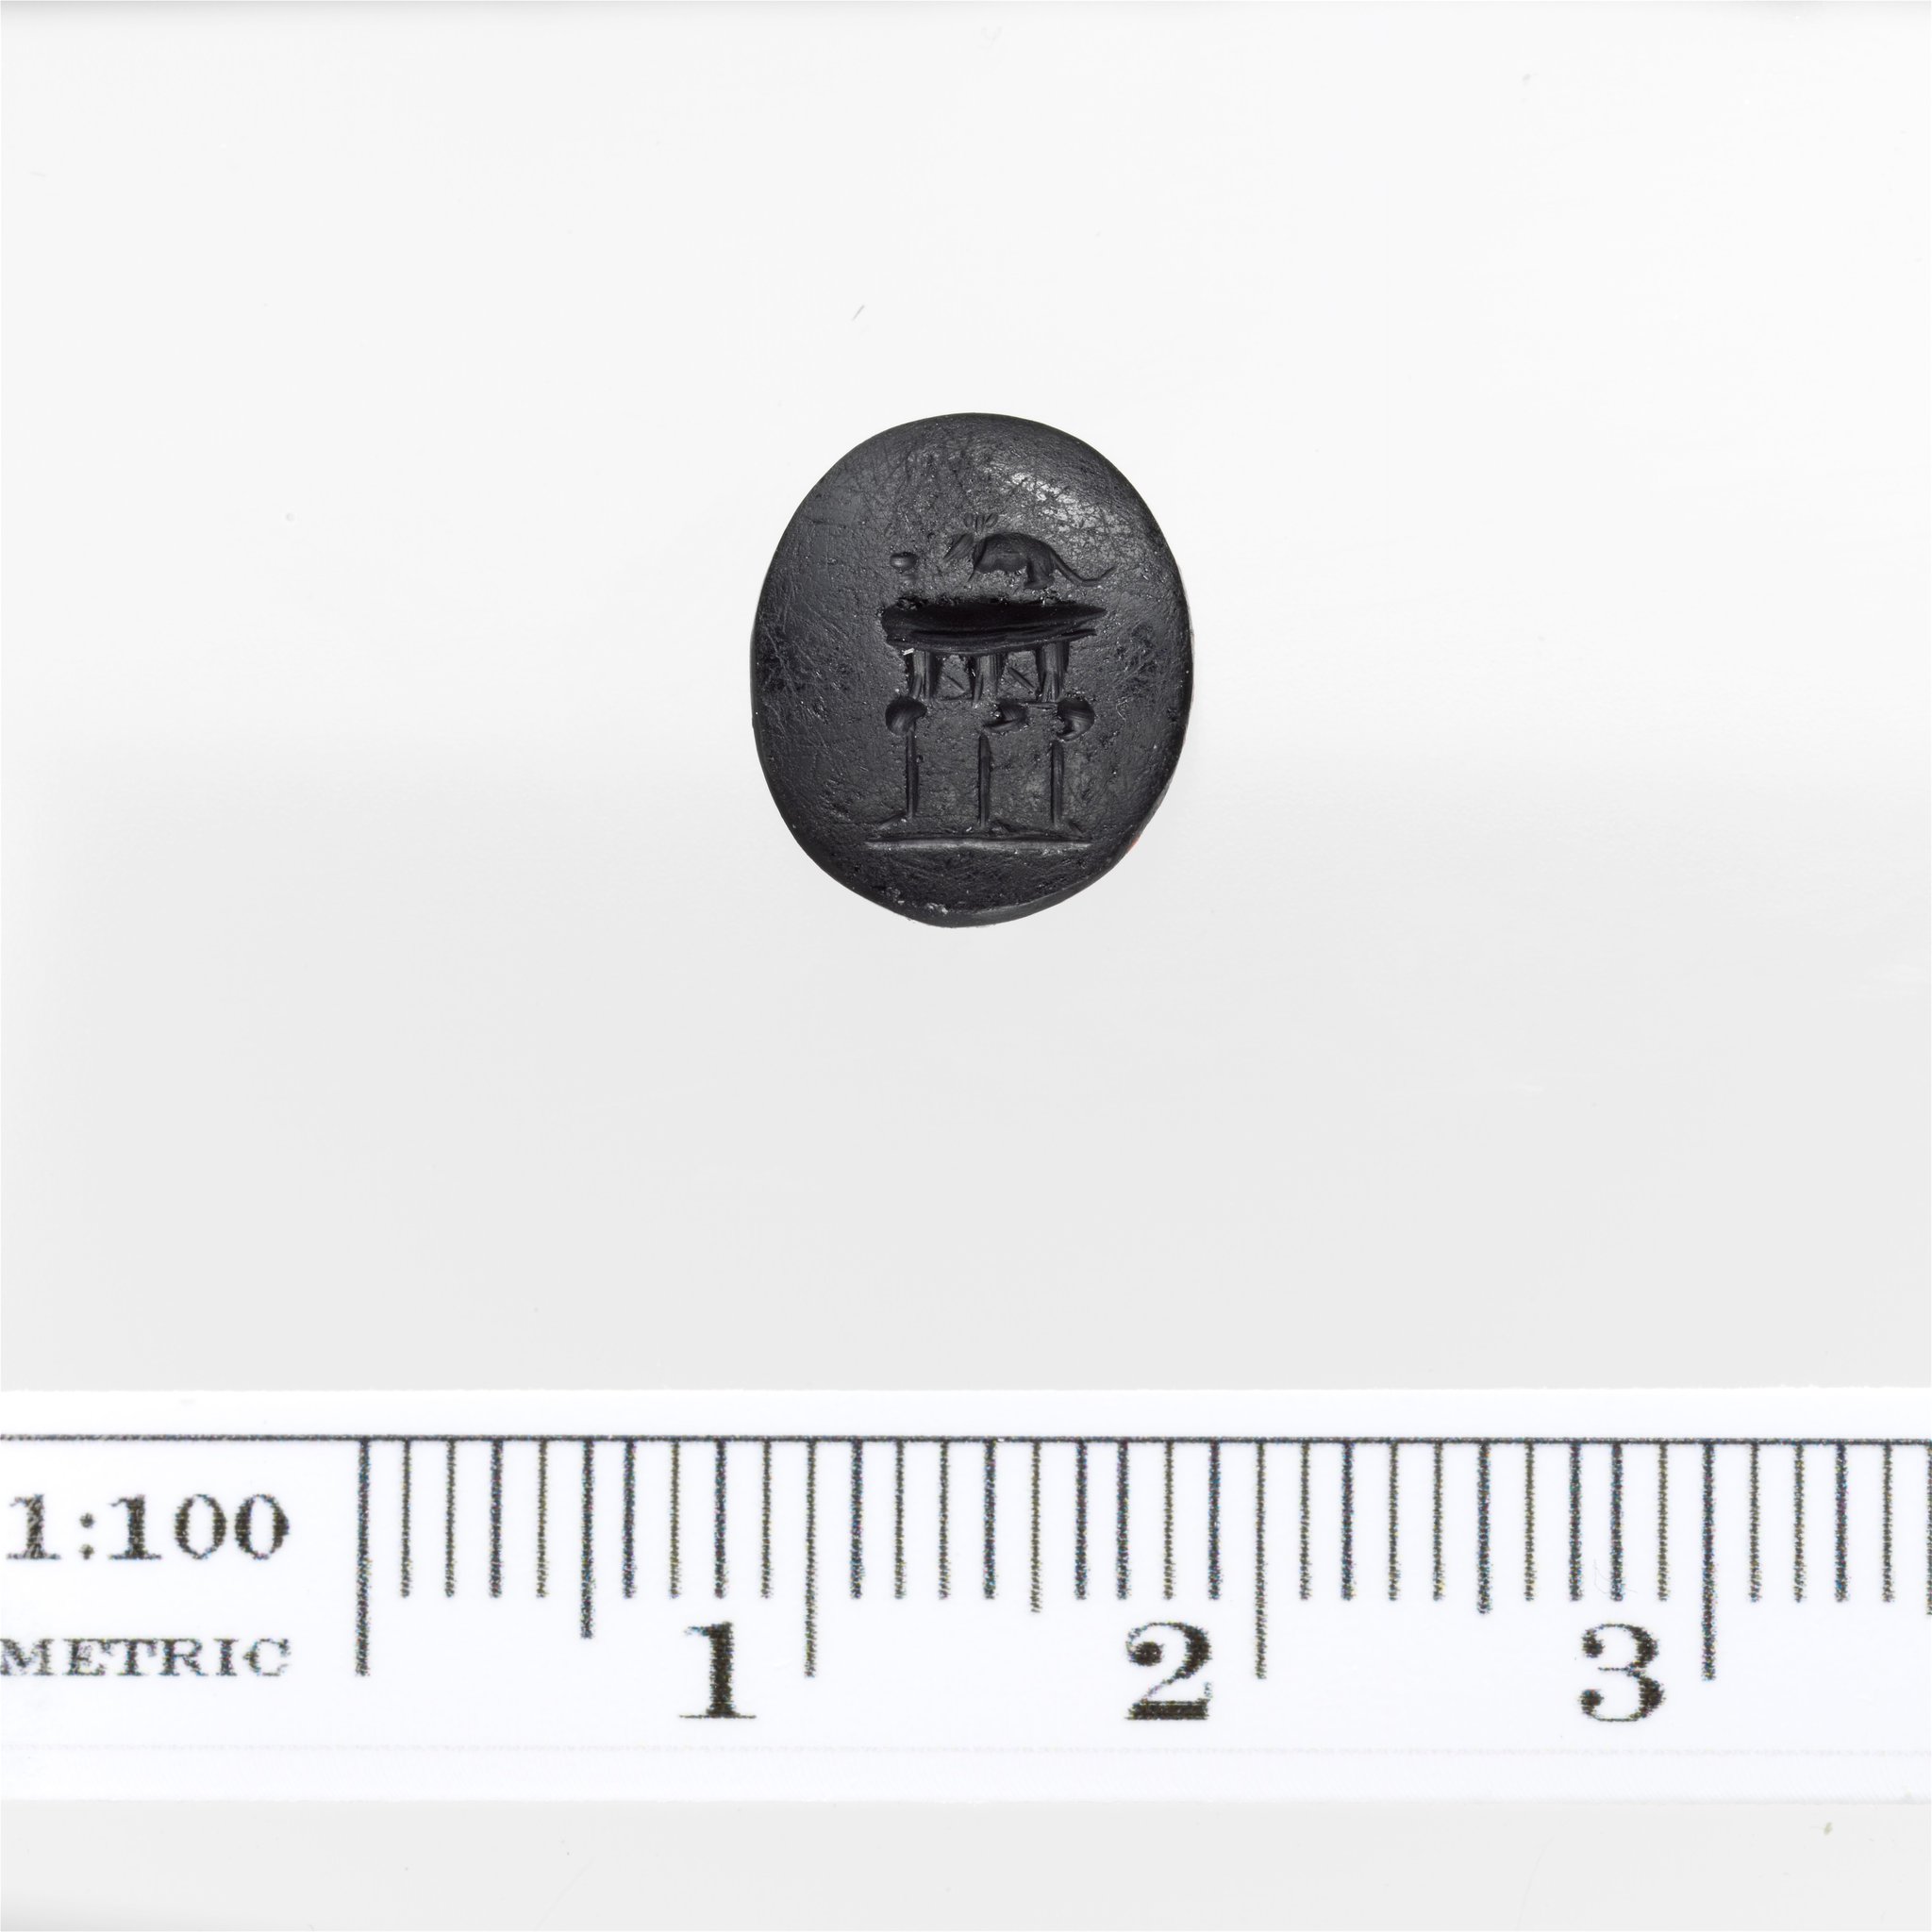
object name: intaglio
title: Black jasper ring stone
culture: roman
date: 100 BCE-300 CE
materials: jasper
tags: mice